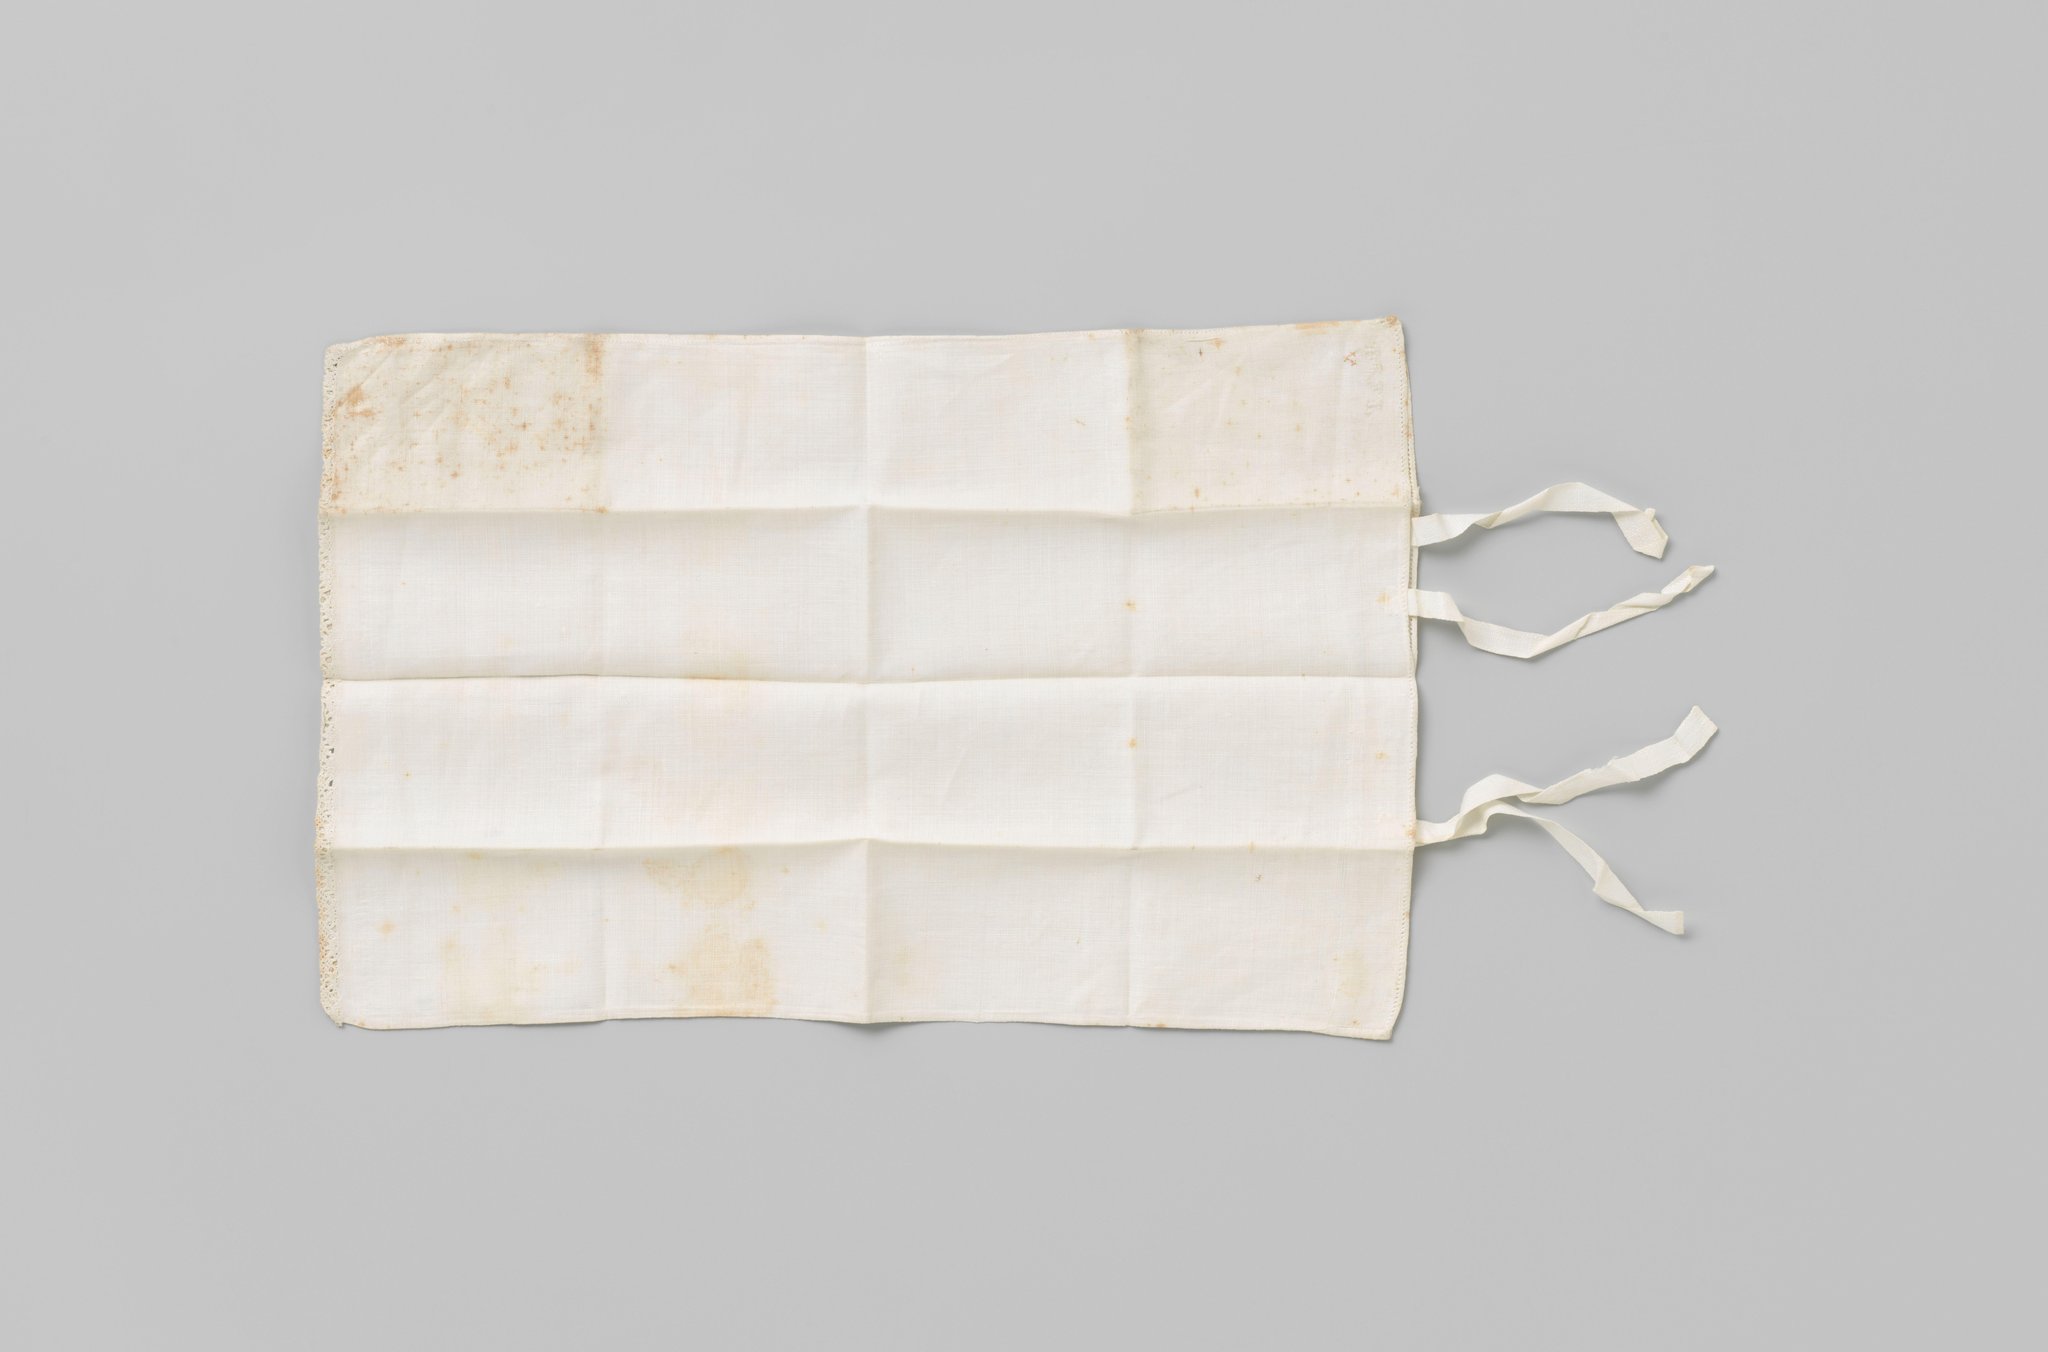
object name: lendensloop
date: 1640-1660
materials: linen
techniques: lace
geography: northern netherlands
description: Lendensloop van linnen, entre-deux van kloskant, merk PVL V en I G.